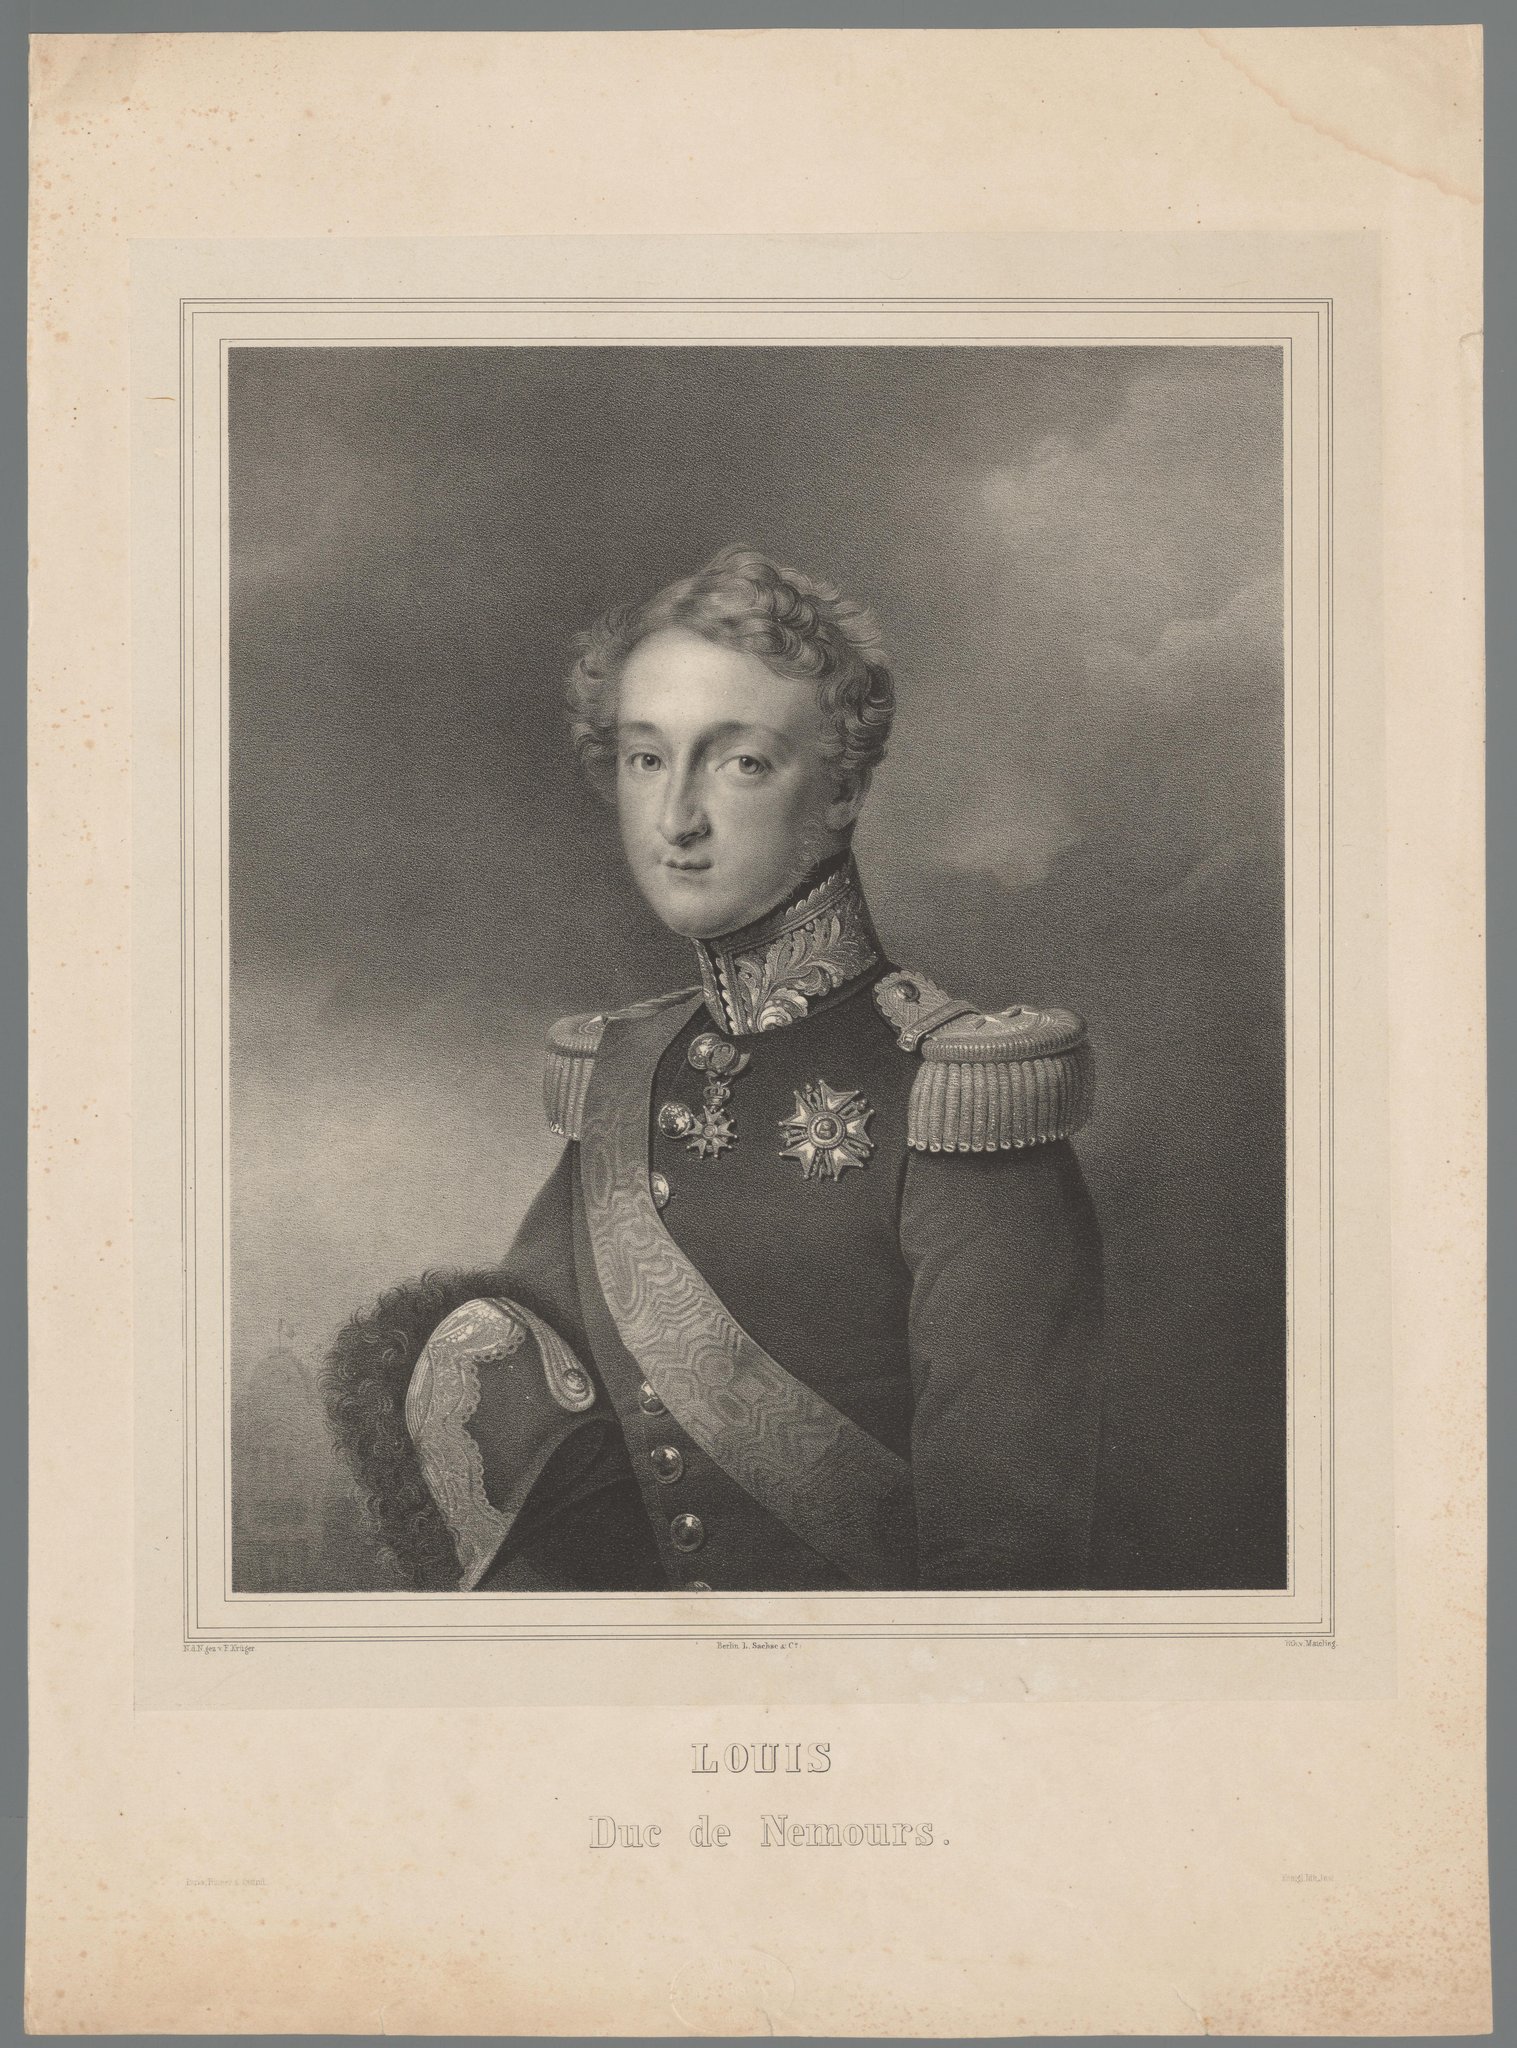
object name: print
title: Louis duc de Nemours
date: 1832-1854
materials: paper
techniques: lithograph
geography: paris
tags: paris, family of a ruler, and court, historical persons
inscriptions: check stamp: Lugt 5005, collector's mark: Lugt 2228